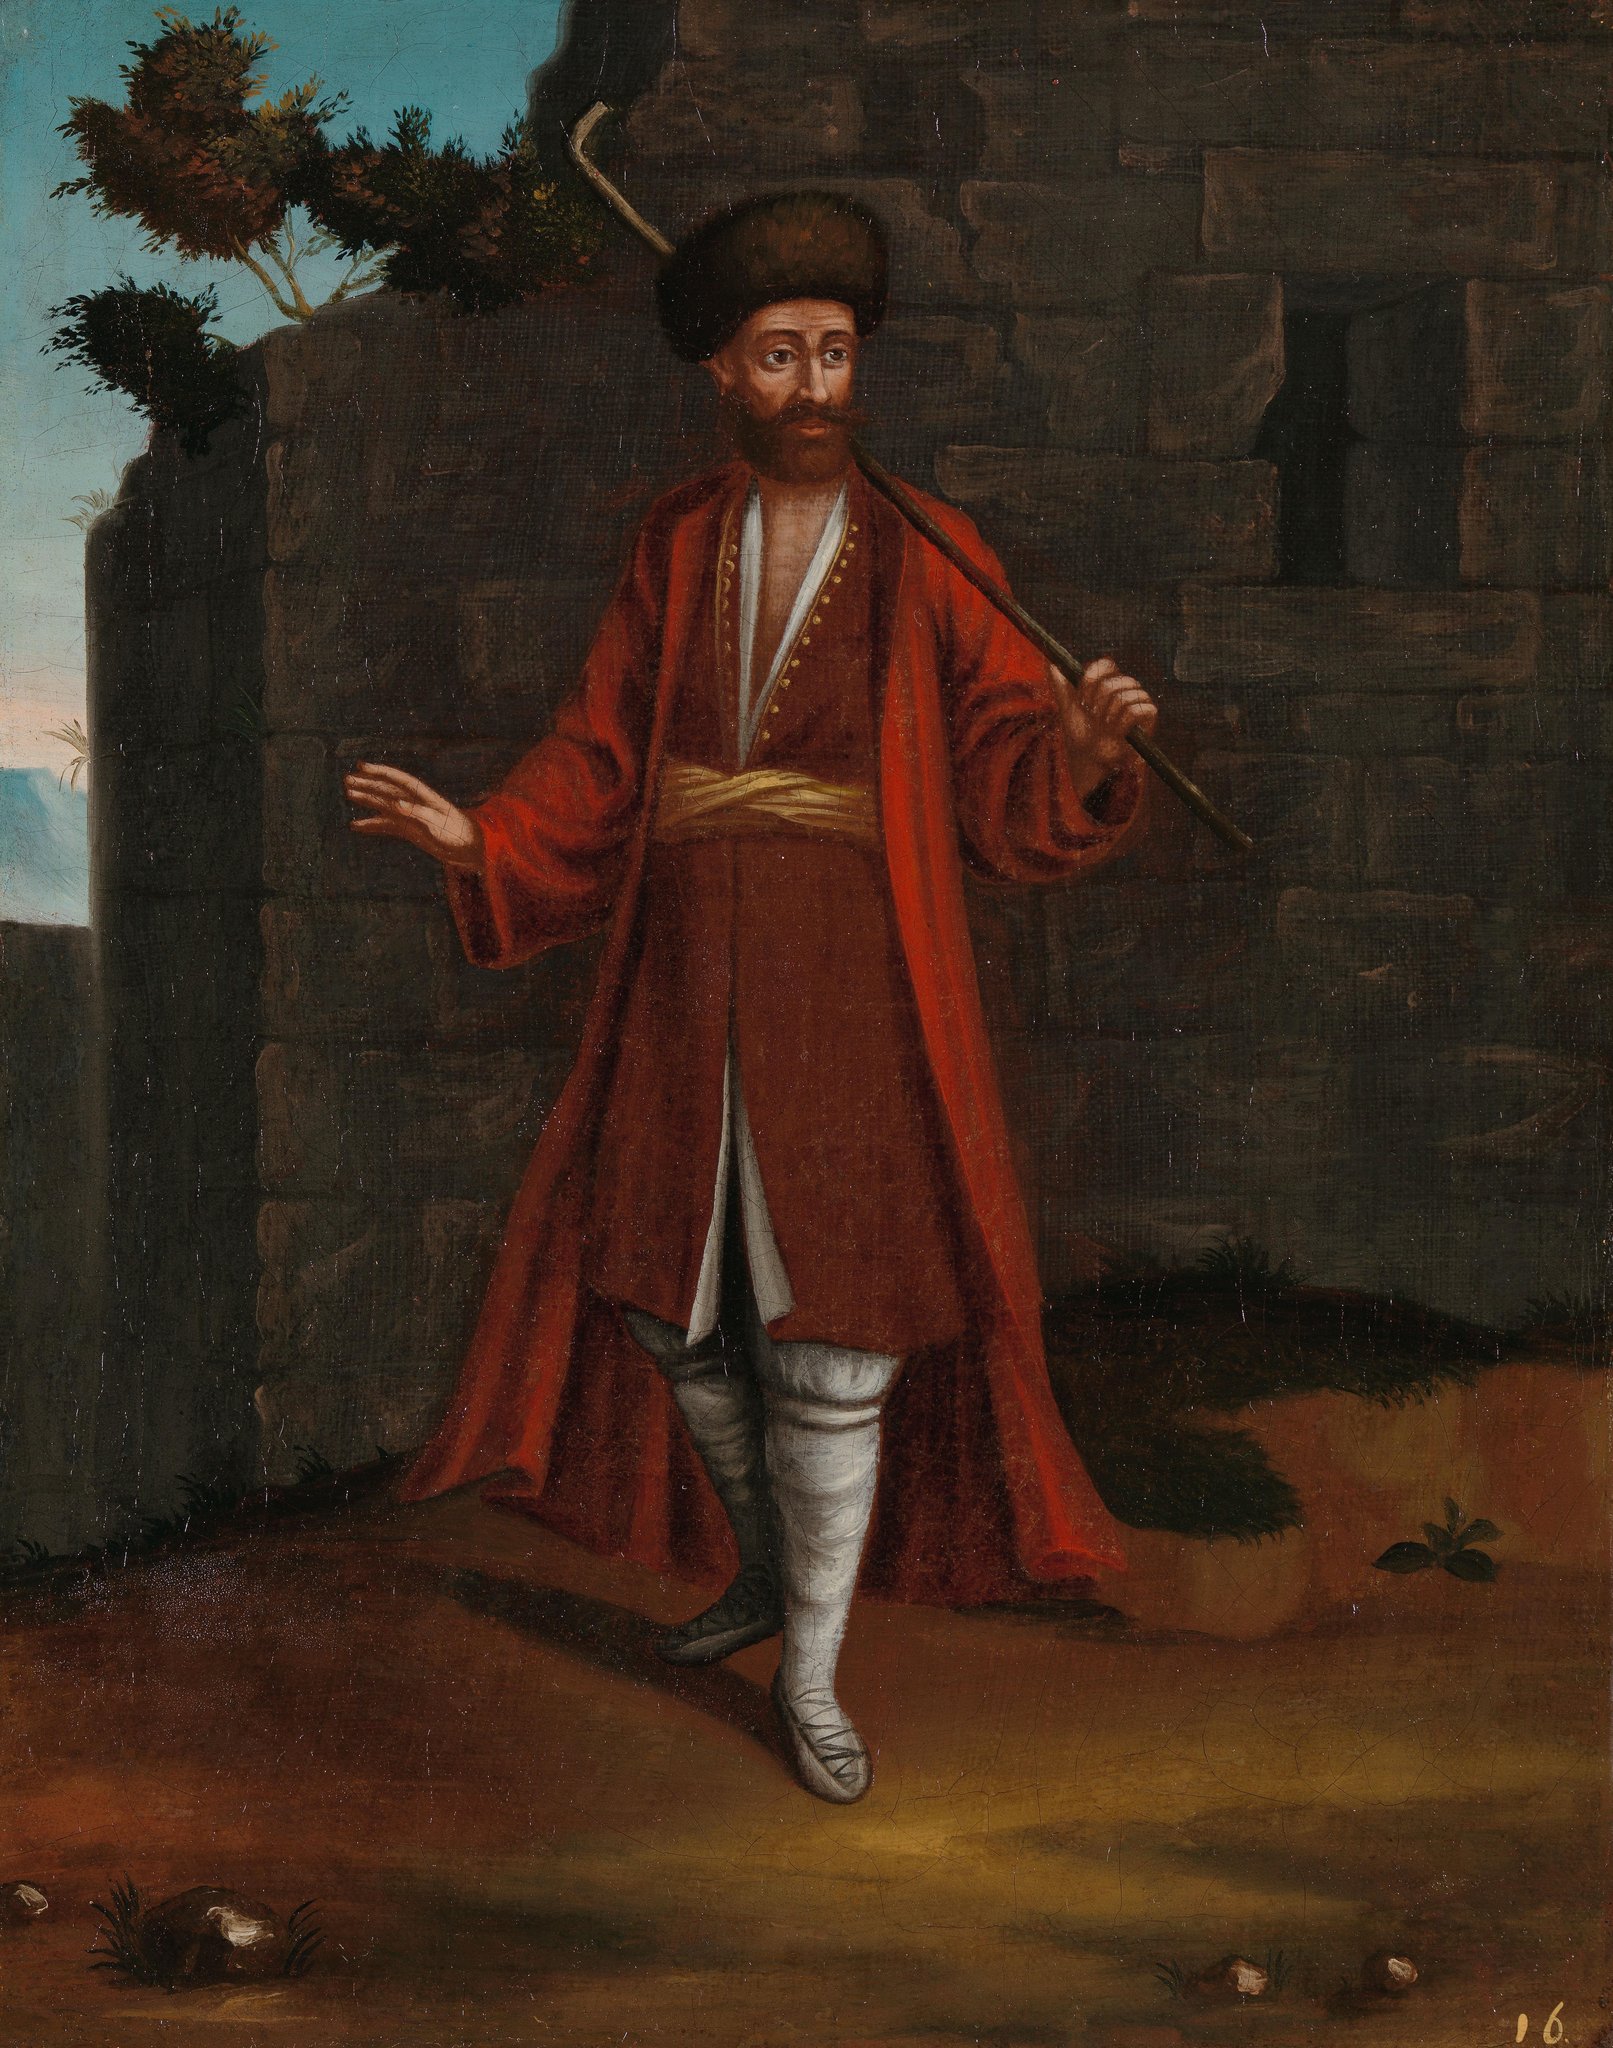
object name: painting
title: Man from the Bulgarian Coast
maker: jean baptiste vanmour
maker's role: painter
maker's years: 1671-1737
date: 1700-1737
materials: canvas, oil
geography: istanbul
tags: standing figure, folk costume, regional costume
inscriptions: inscription: ‘Boulgar / Een man van de kust Bolgardo’, number: ‘16’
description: Een Bulgaar van de kust. Staande, ten voeten uit, voor een ruïne, de staf over de linkerschouder.